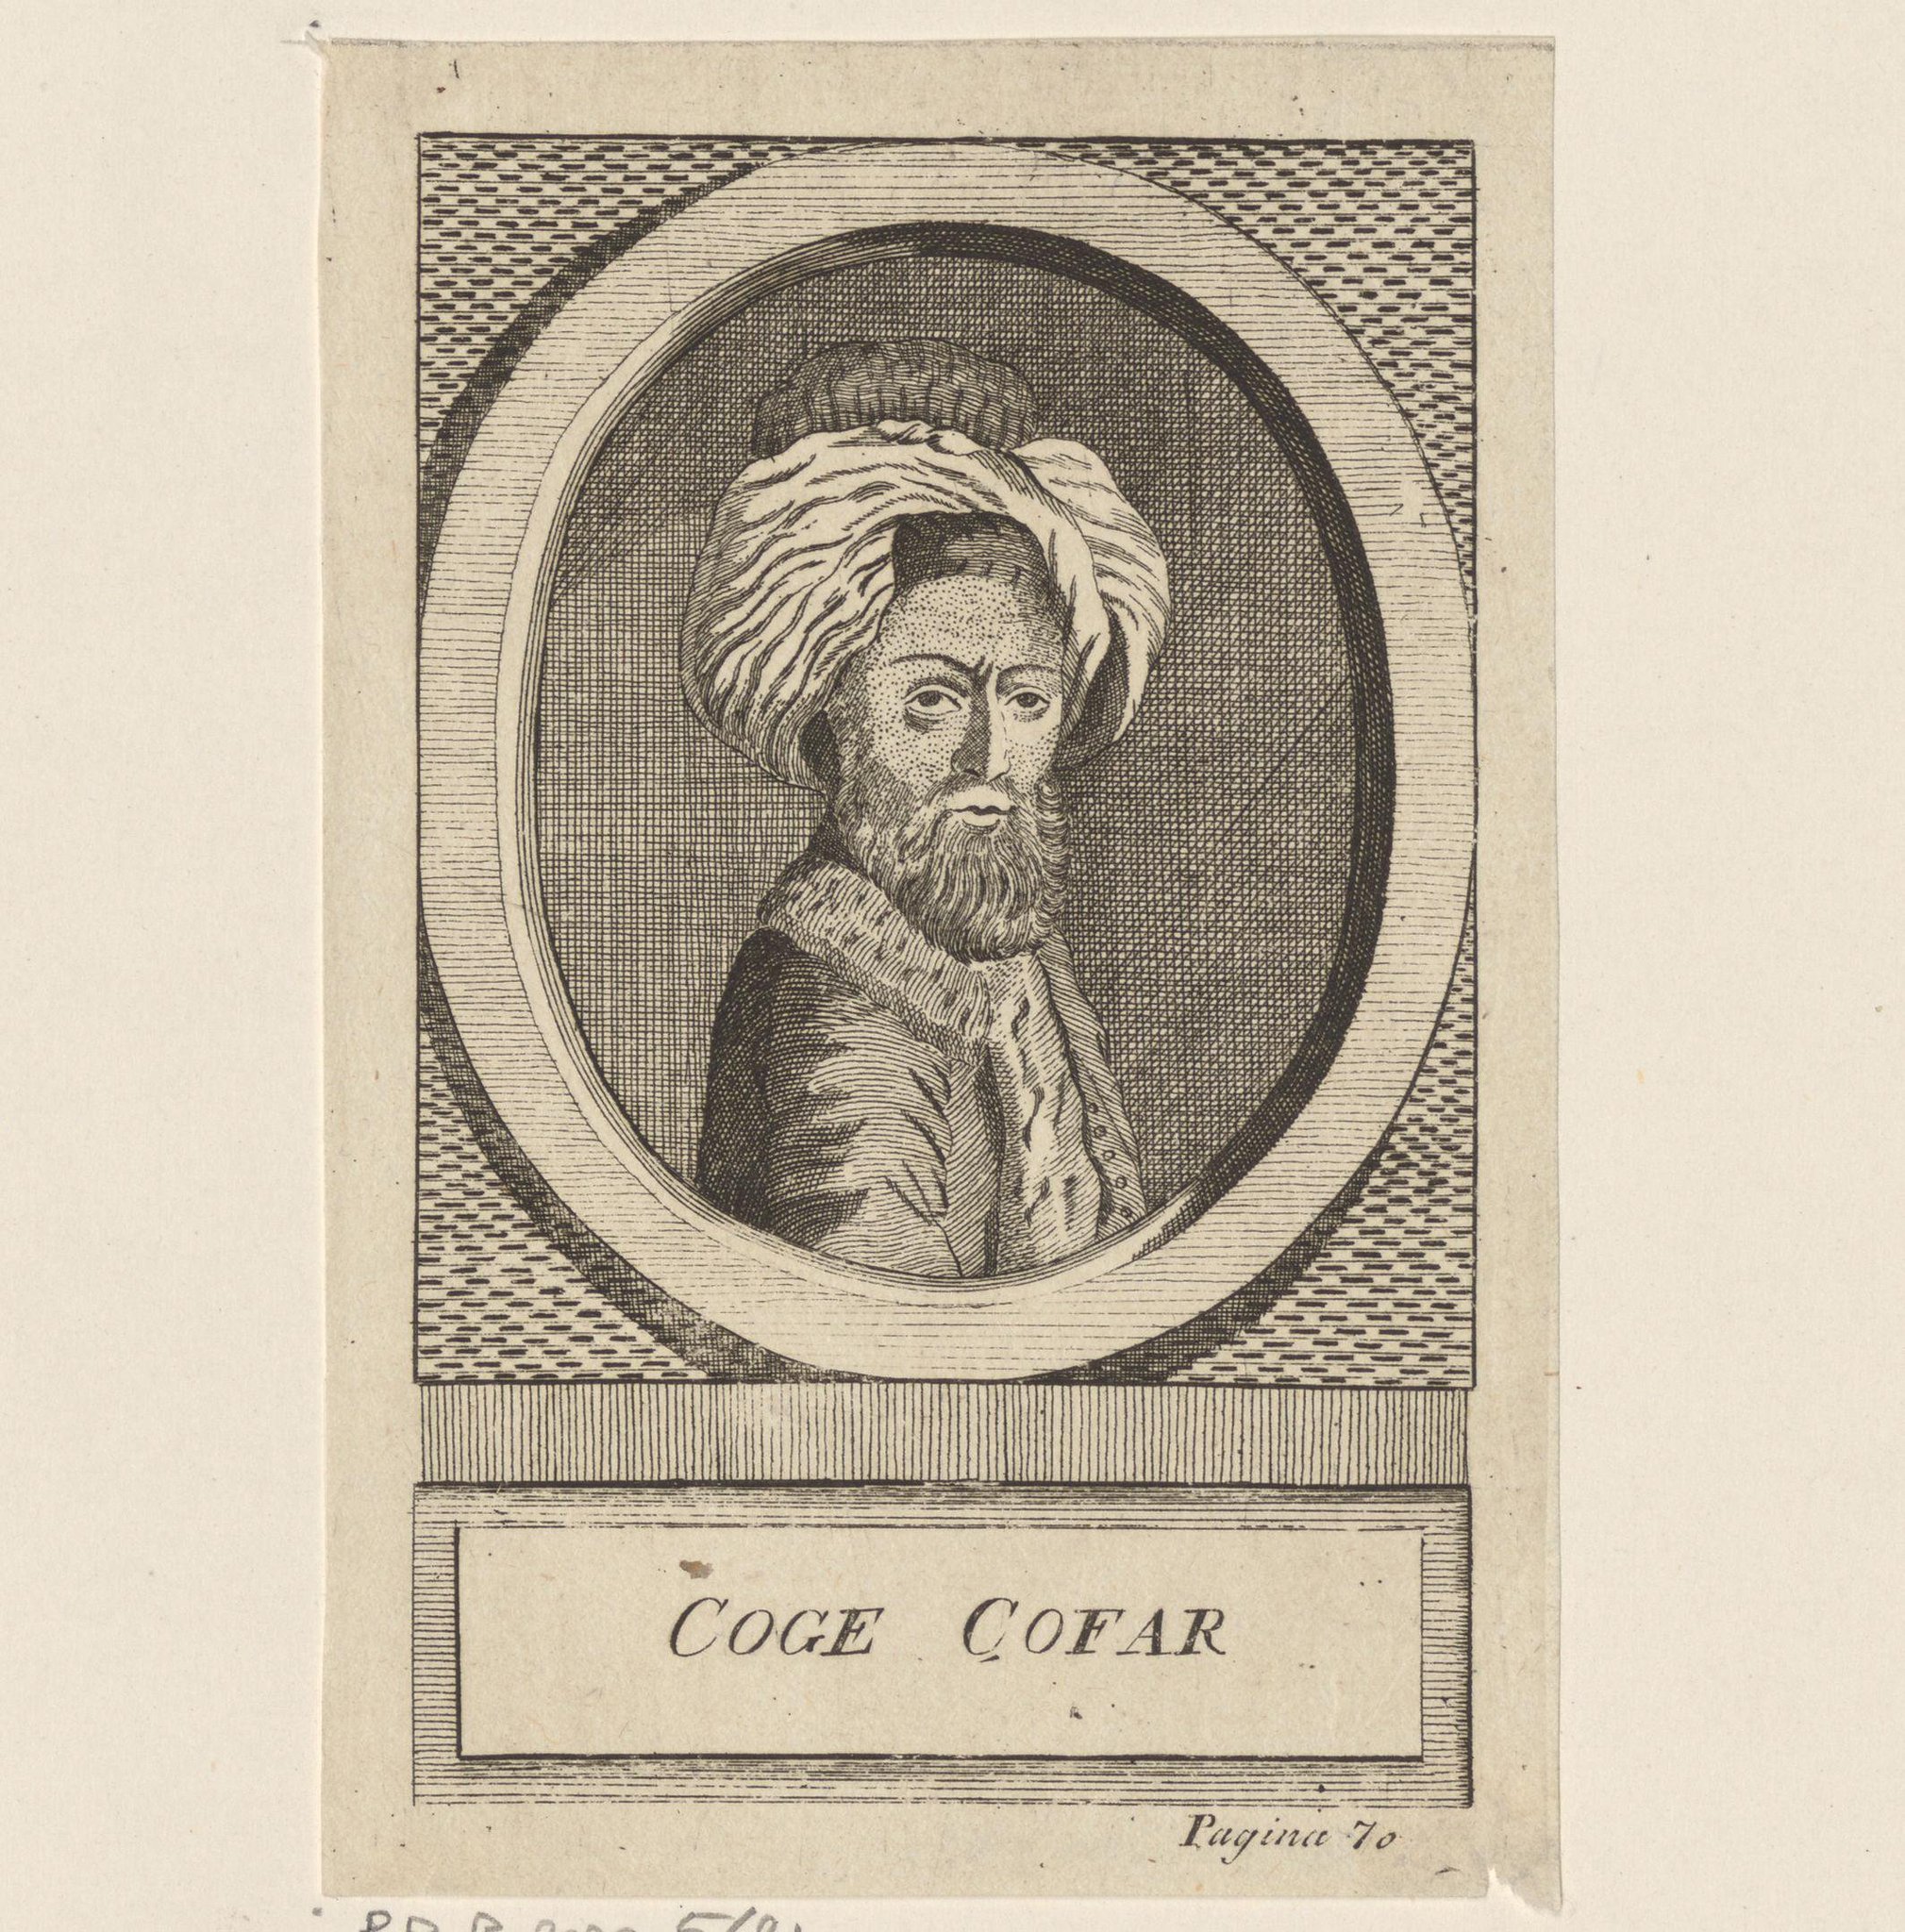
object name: print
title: Portret van Khoja Zufar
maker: léon-louis chapon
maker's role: print maker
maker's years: 1836-1918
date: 1775-1824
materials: paper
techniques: engraving, etching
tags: historical persons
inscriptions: : Lugt 2228